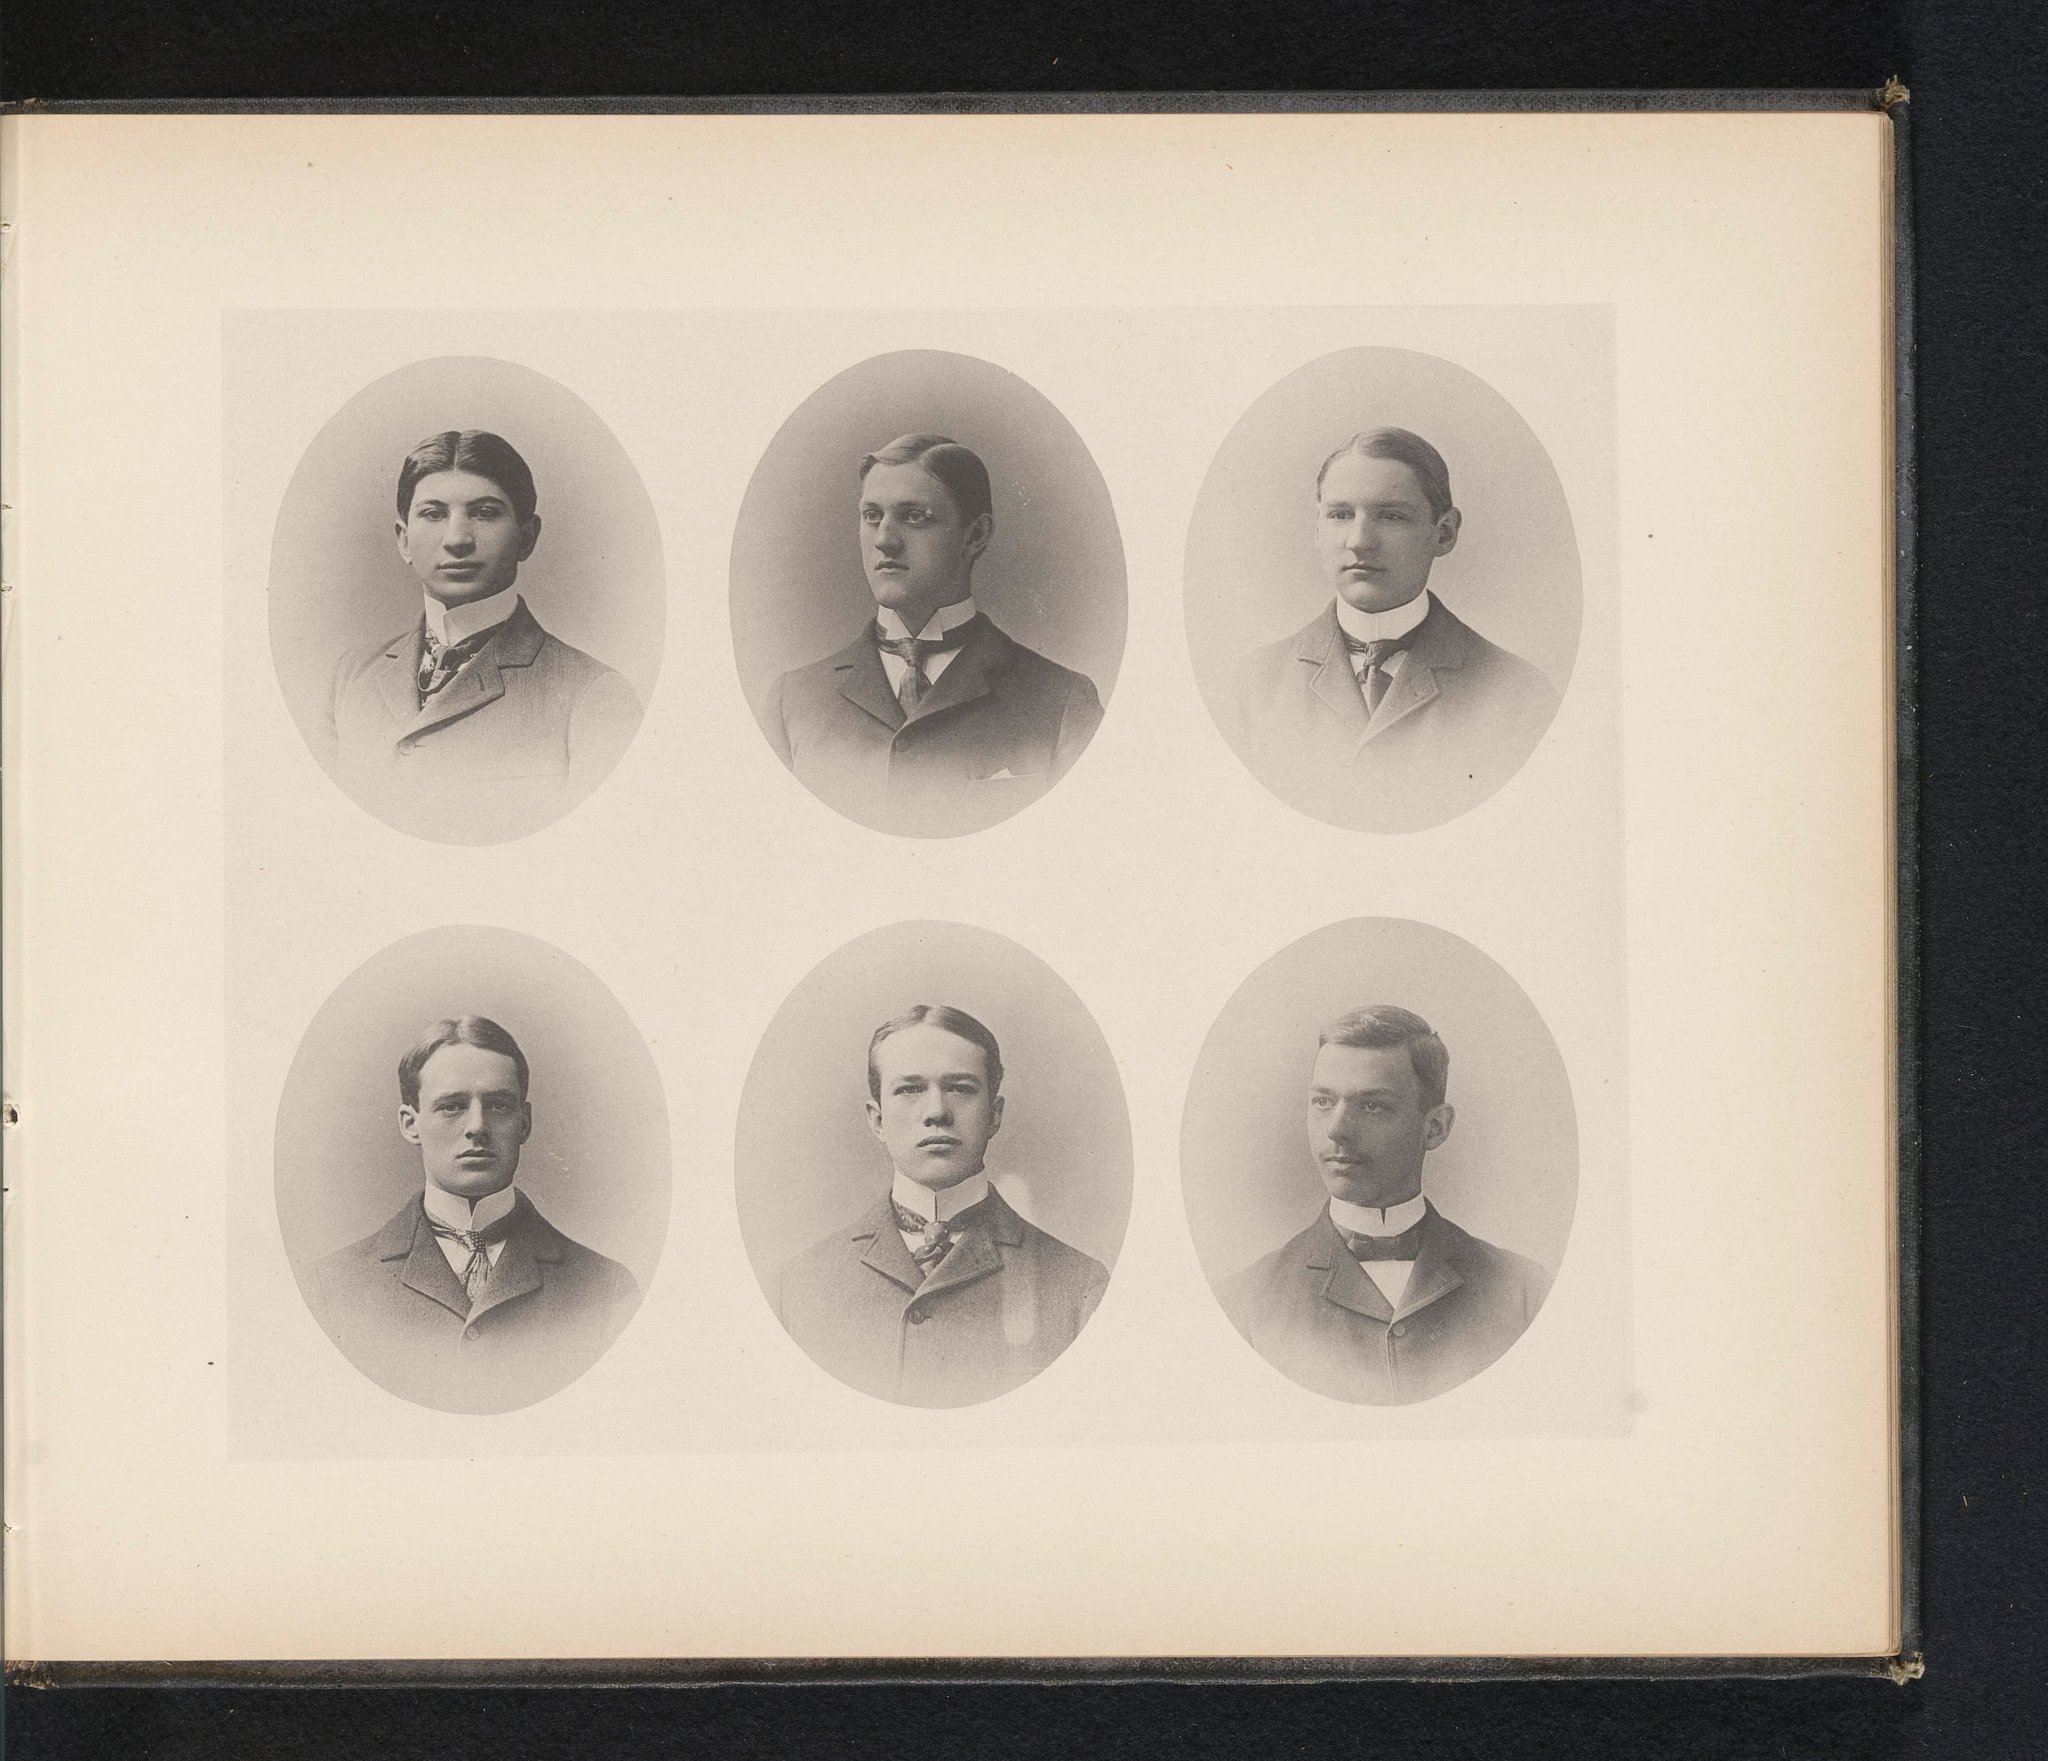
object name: photomechanical print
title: Zes portretten van afgestudeerde studenten van Yale University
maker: Anonymous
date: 1895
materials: paper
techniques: photograph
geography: new york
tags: student